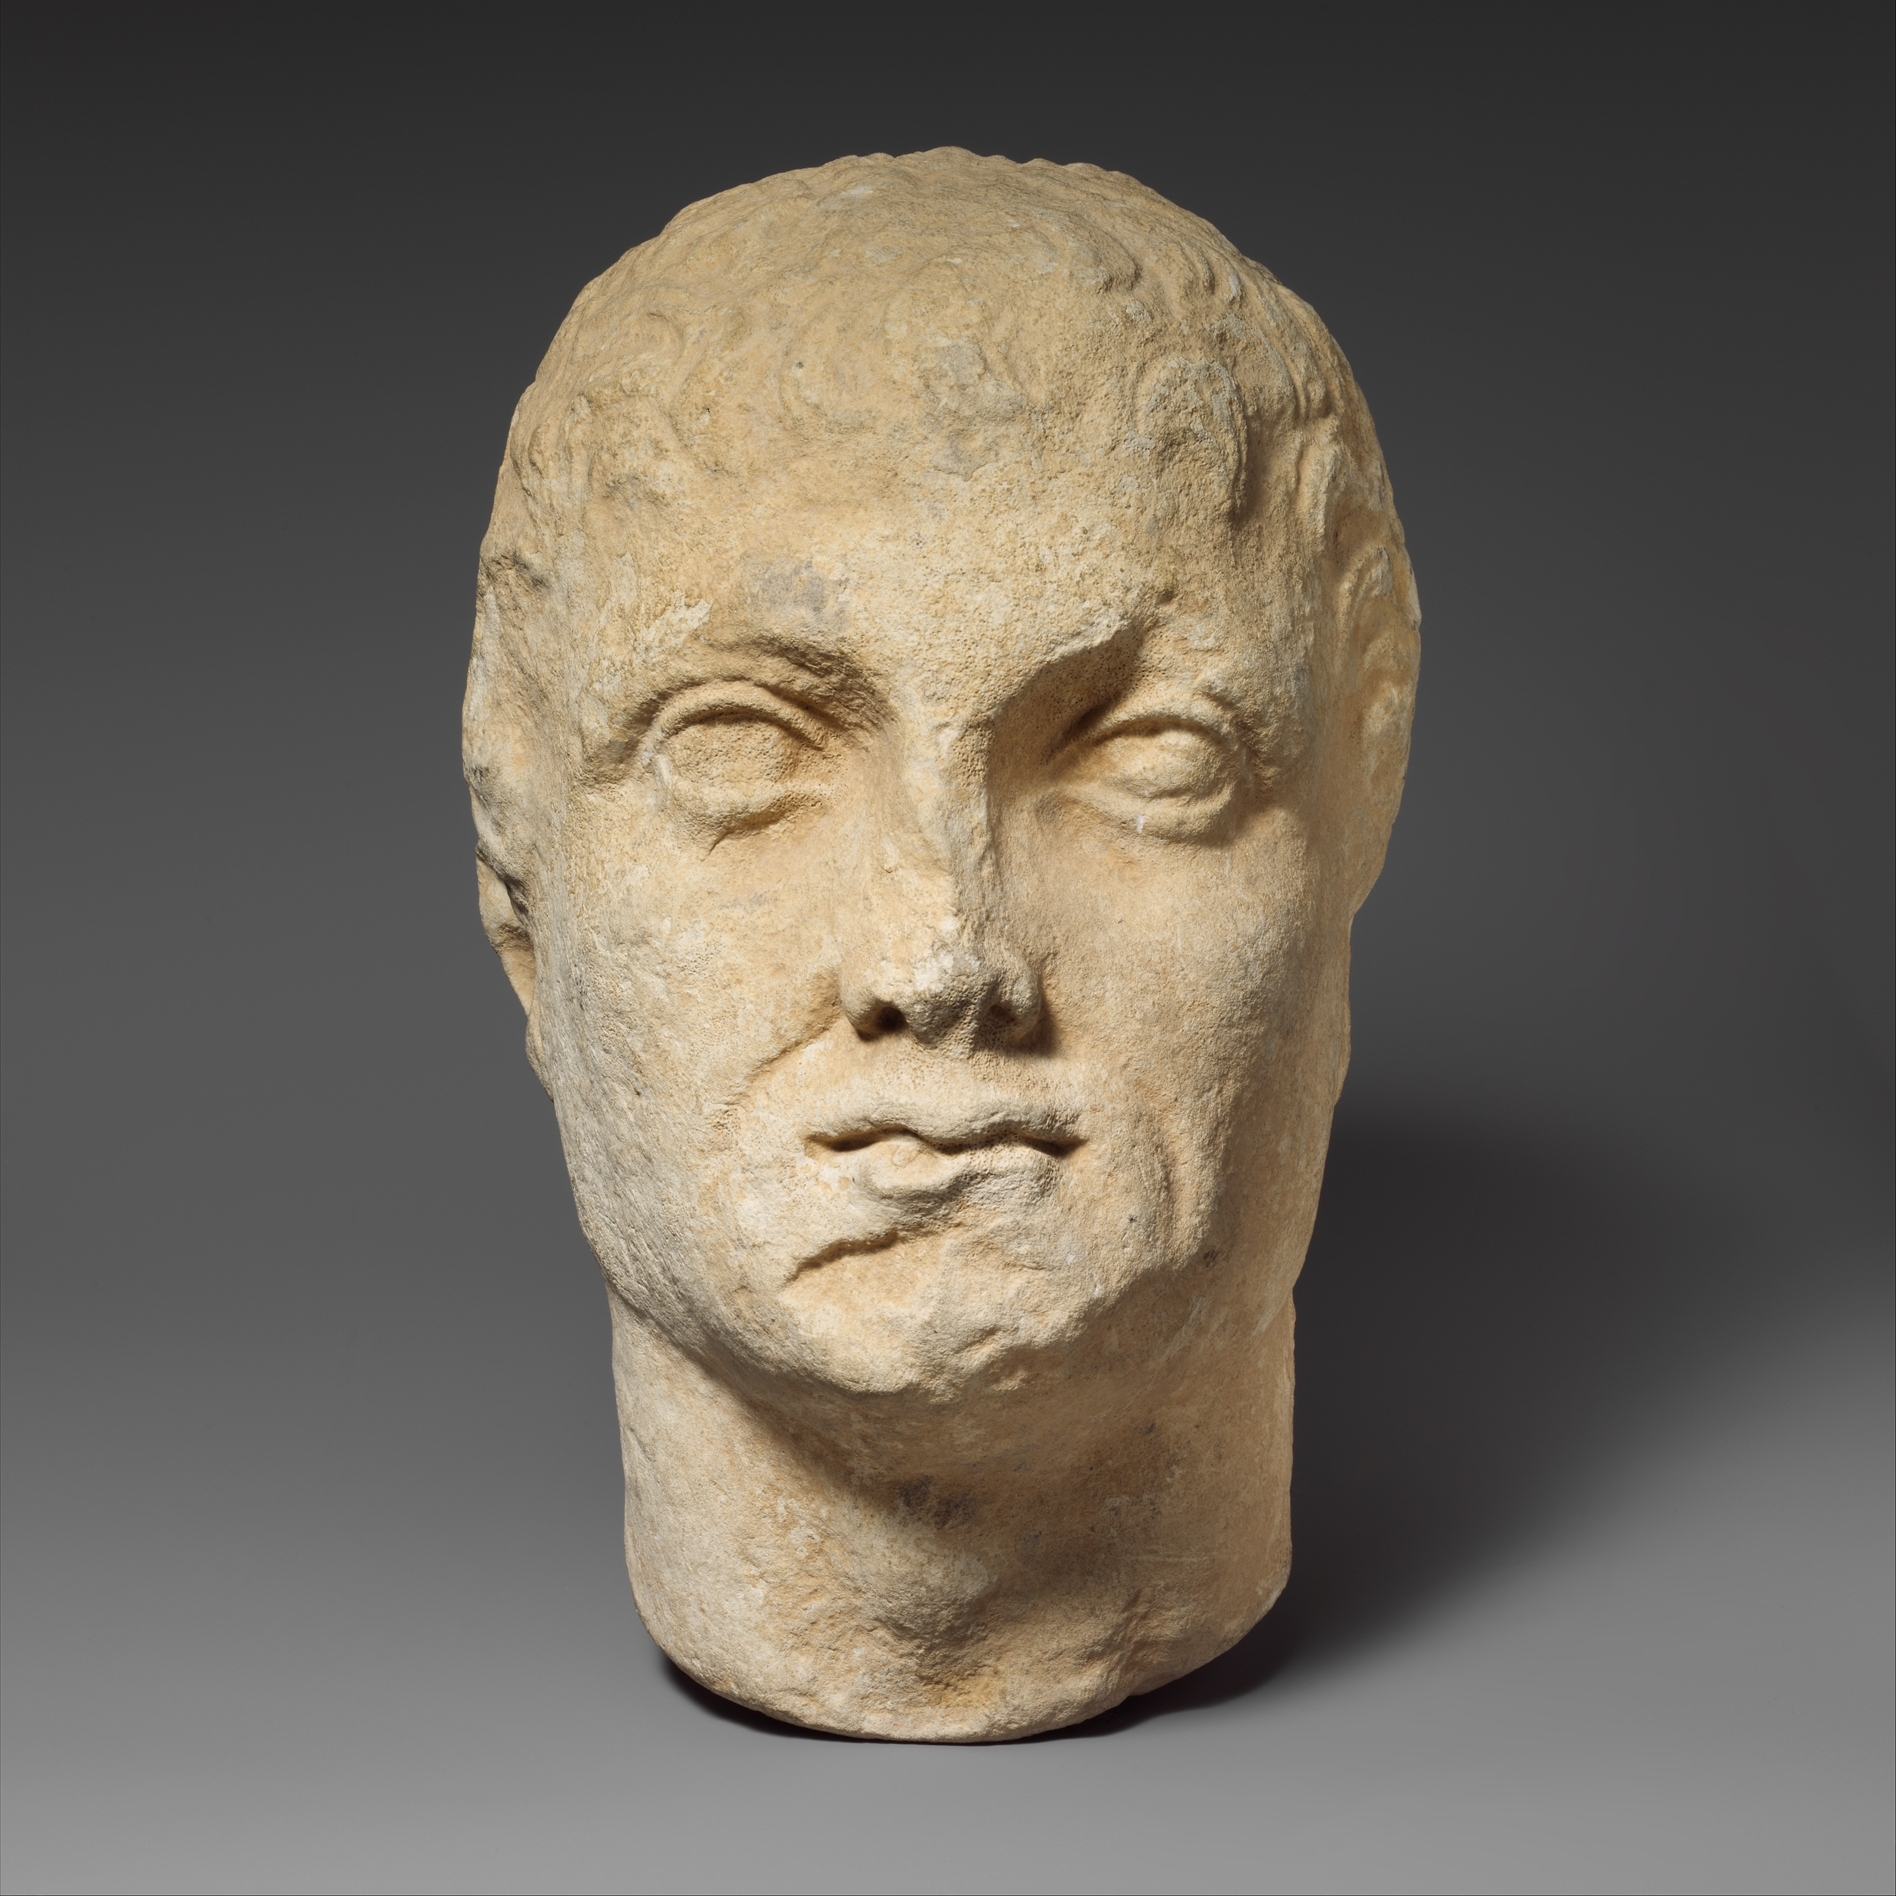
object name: head of an elderly man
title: Limestone head of a beardless male votary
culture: cypriot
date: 100-1 BCE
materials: limestone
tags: heads,men